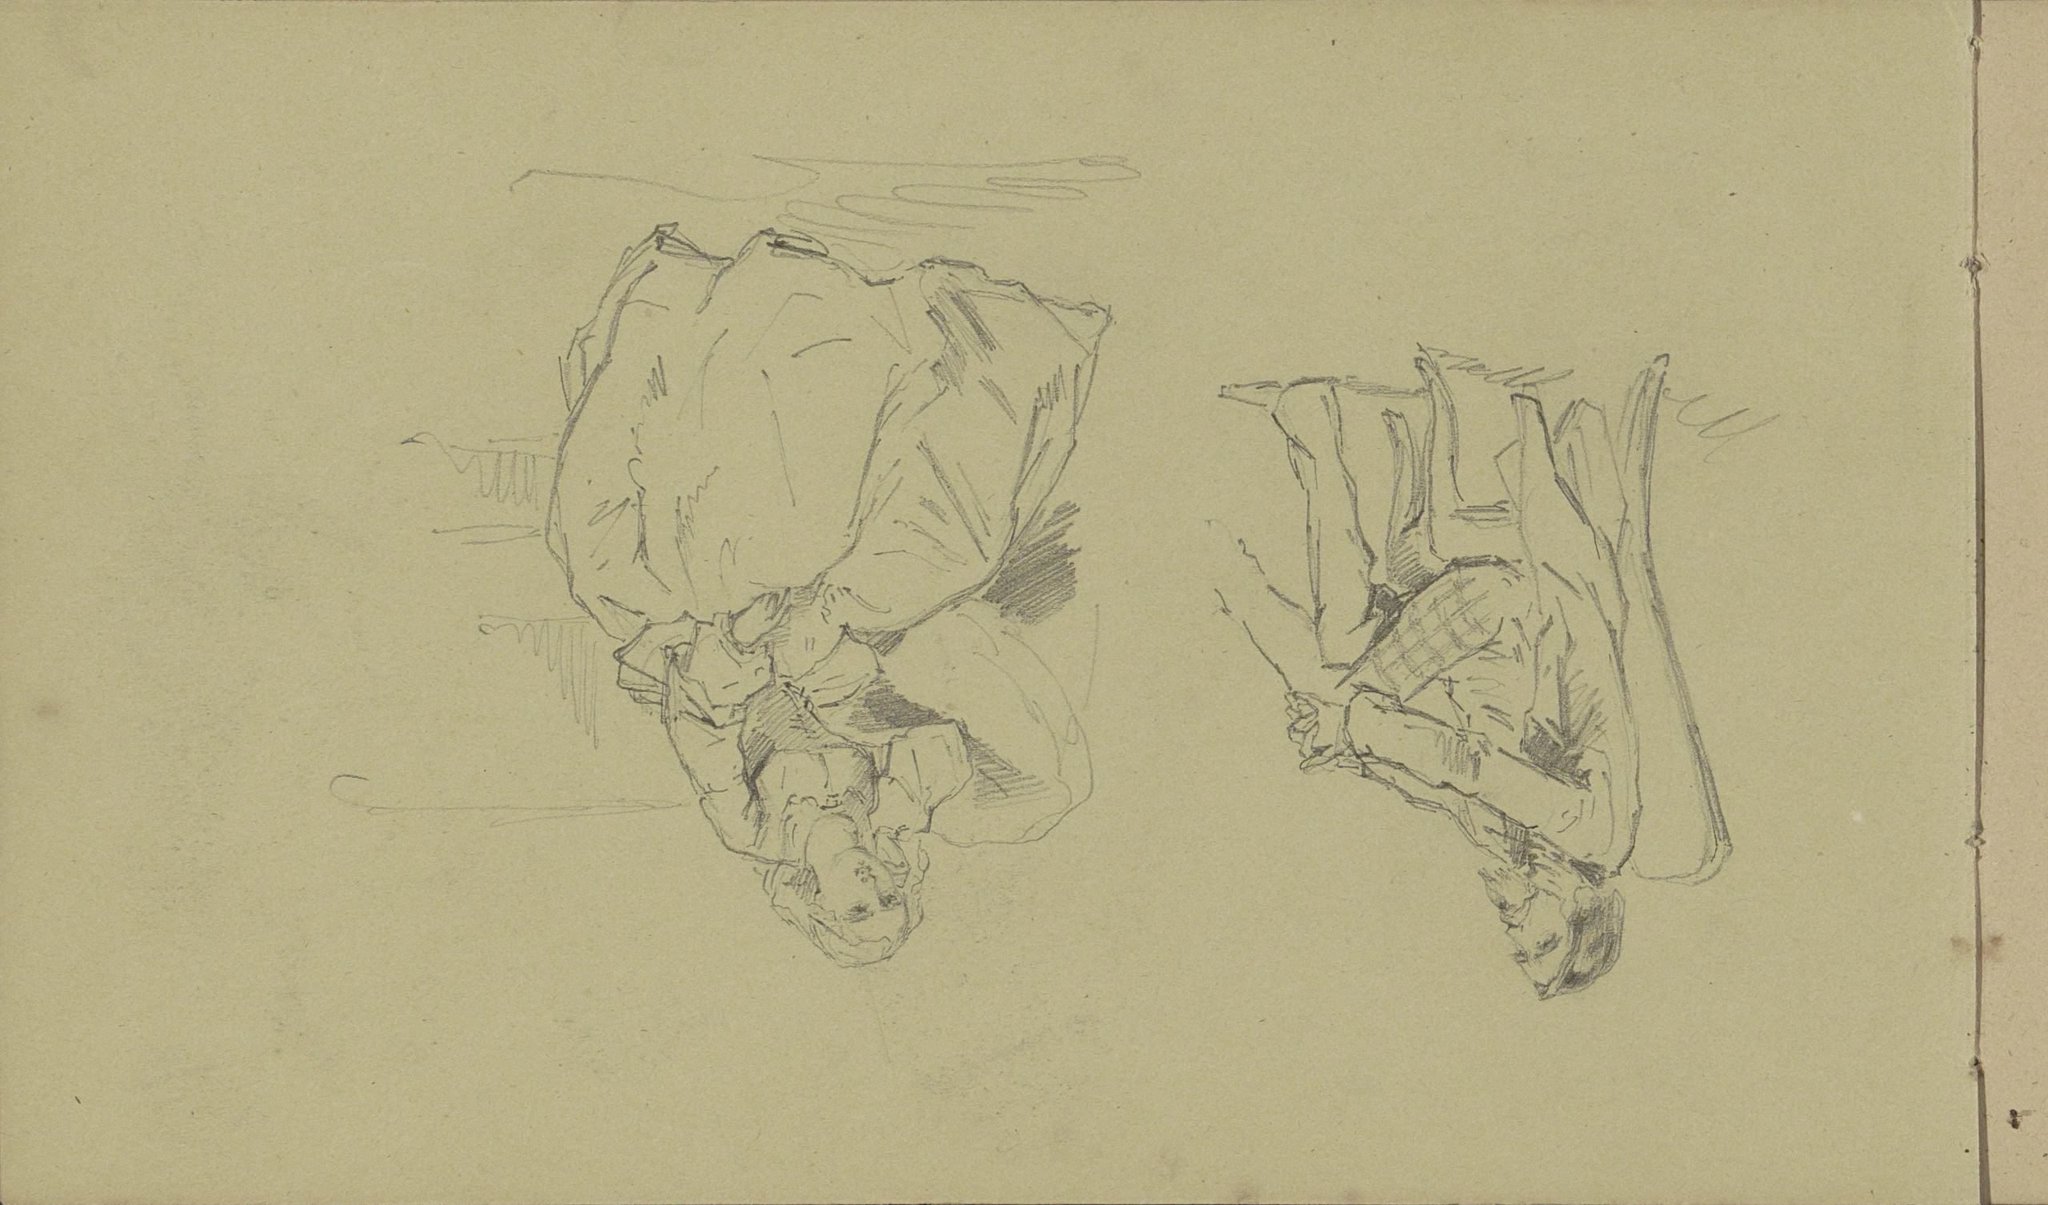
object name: sketchbook leaf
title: Zittende man en vrouw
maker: charles rochussen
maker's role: draughtsman, painter, print maker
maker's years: 1814-1894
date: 1840-1860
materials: paper, pencil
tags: sitting figure, table, couch, sofa, settee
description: Blad 33 verso uit een schetsboek met 38 bladen.